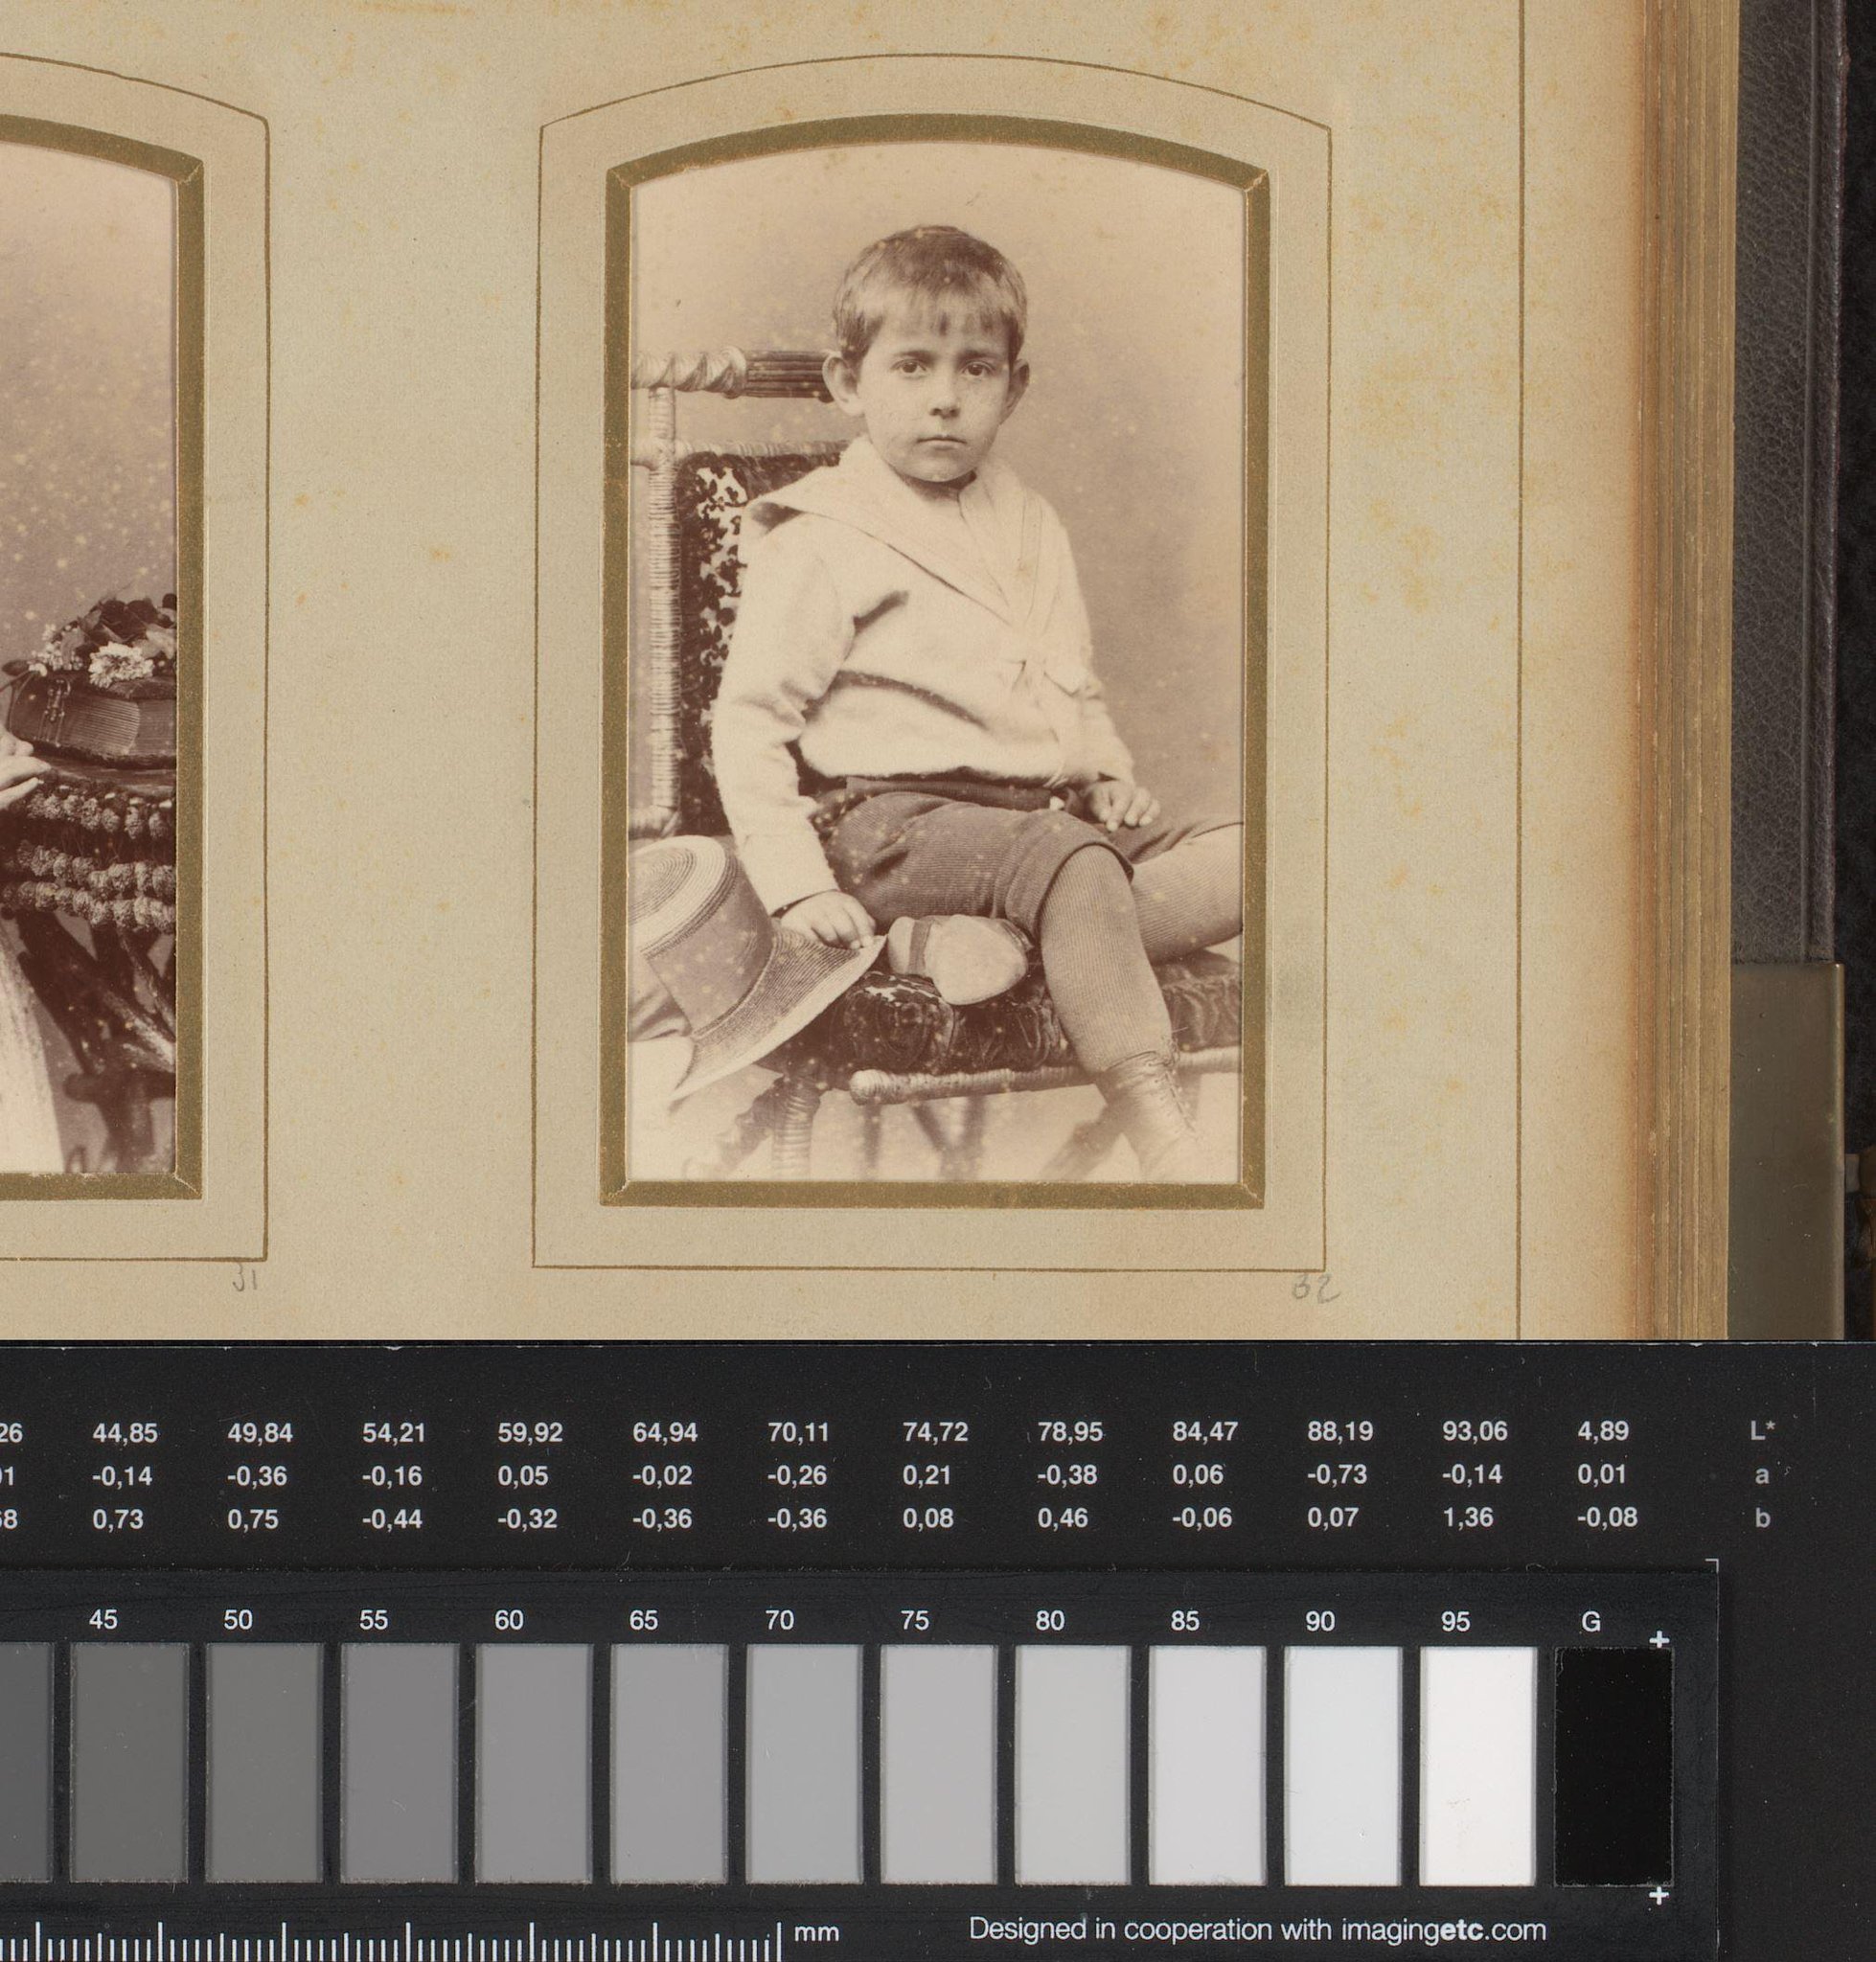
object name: carte de visite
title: Studioportret van Dolph Kessler met strooien hoed op jeugdige leeftijd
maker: kameke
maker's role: painter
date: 1889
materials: paper, photographic support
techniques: photography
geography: the hague